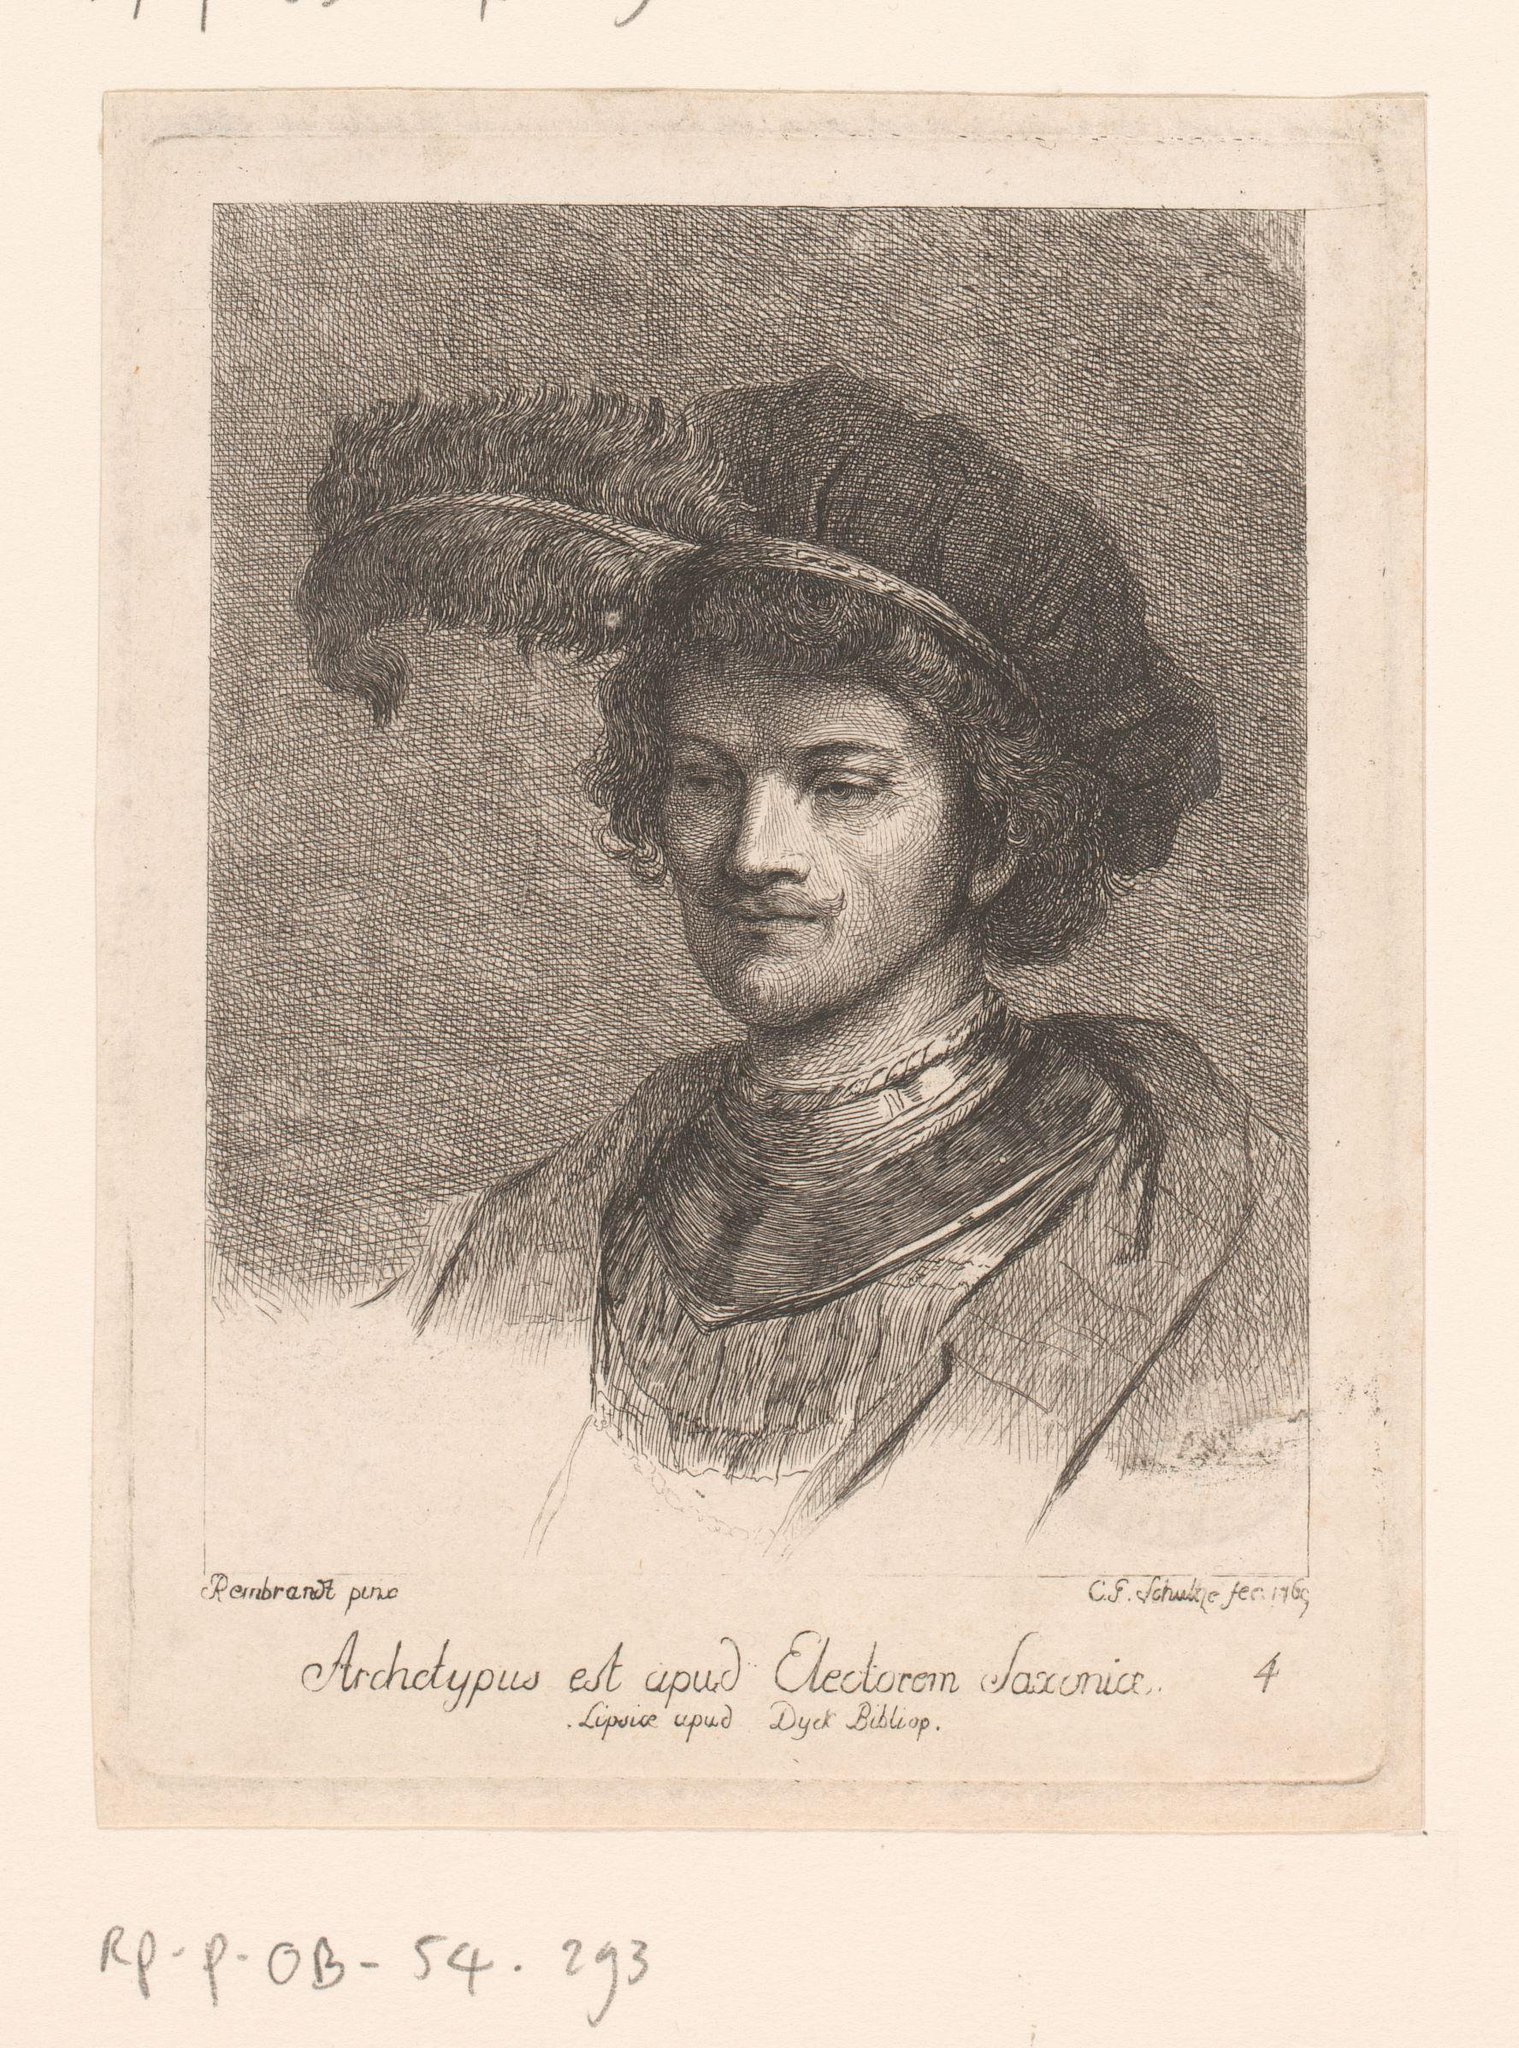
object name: print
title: Mensen in de stijl van Rembrandt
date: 1769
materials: paper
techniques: etching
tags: youth, adolescent, head-gear: beret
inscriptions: collector's mark: Lugt 240